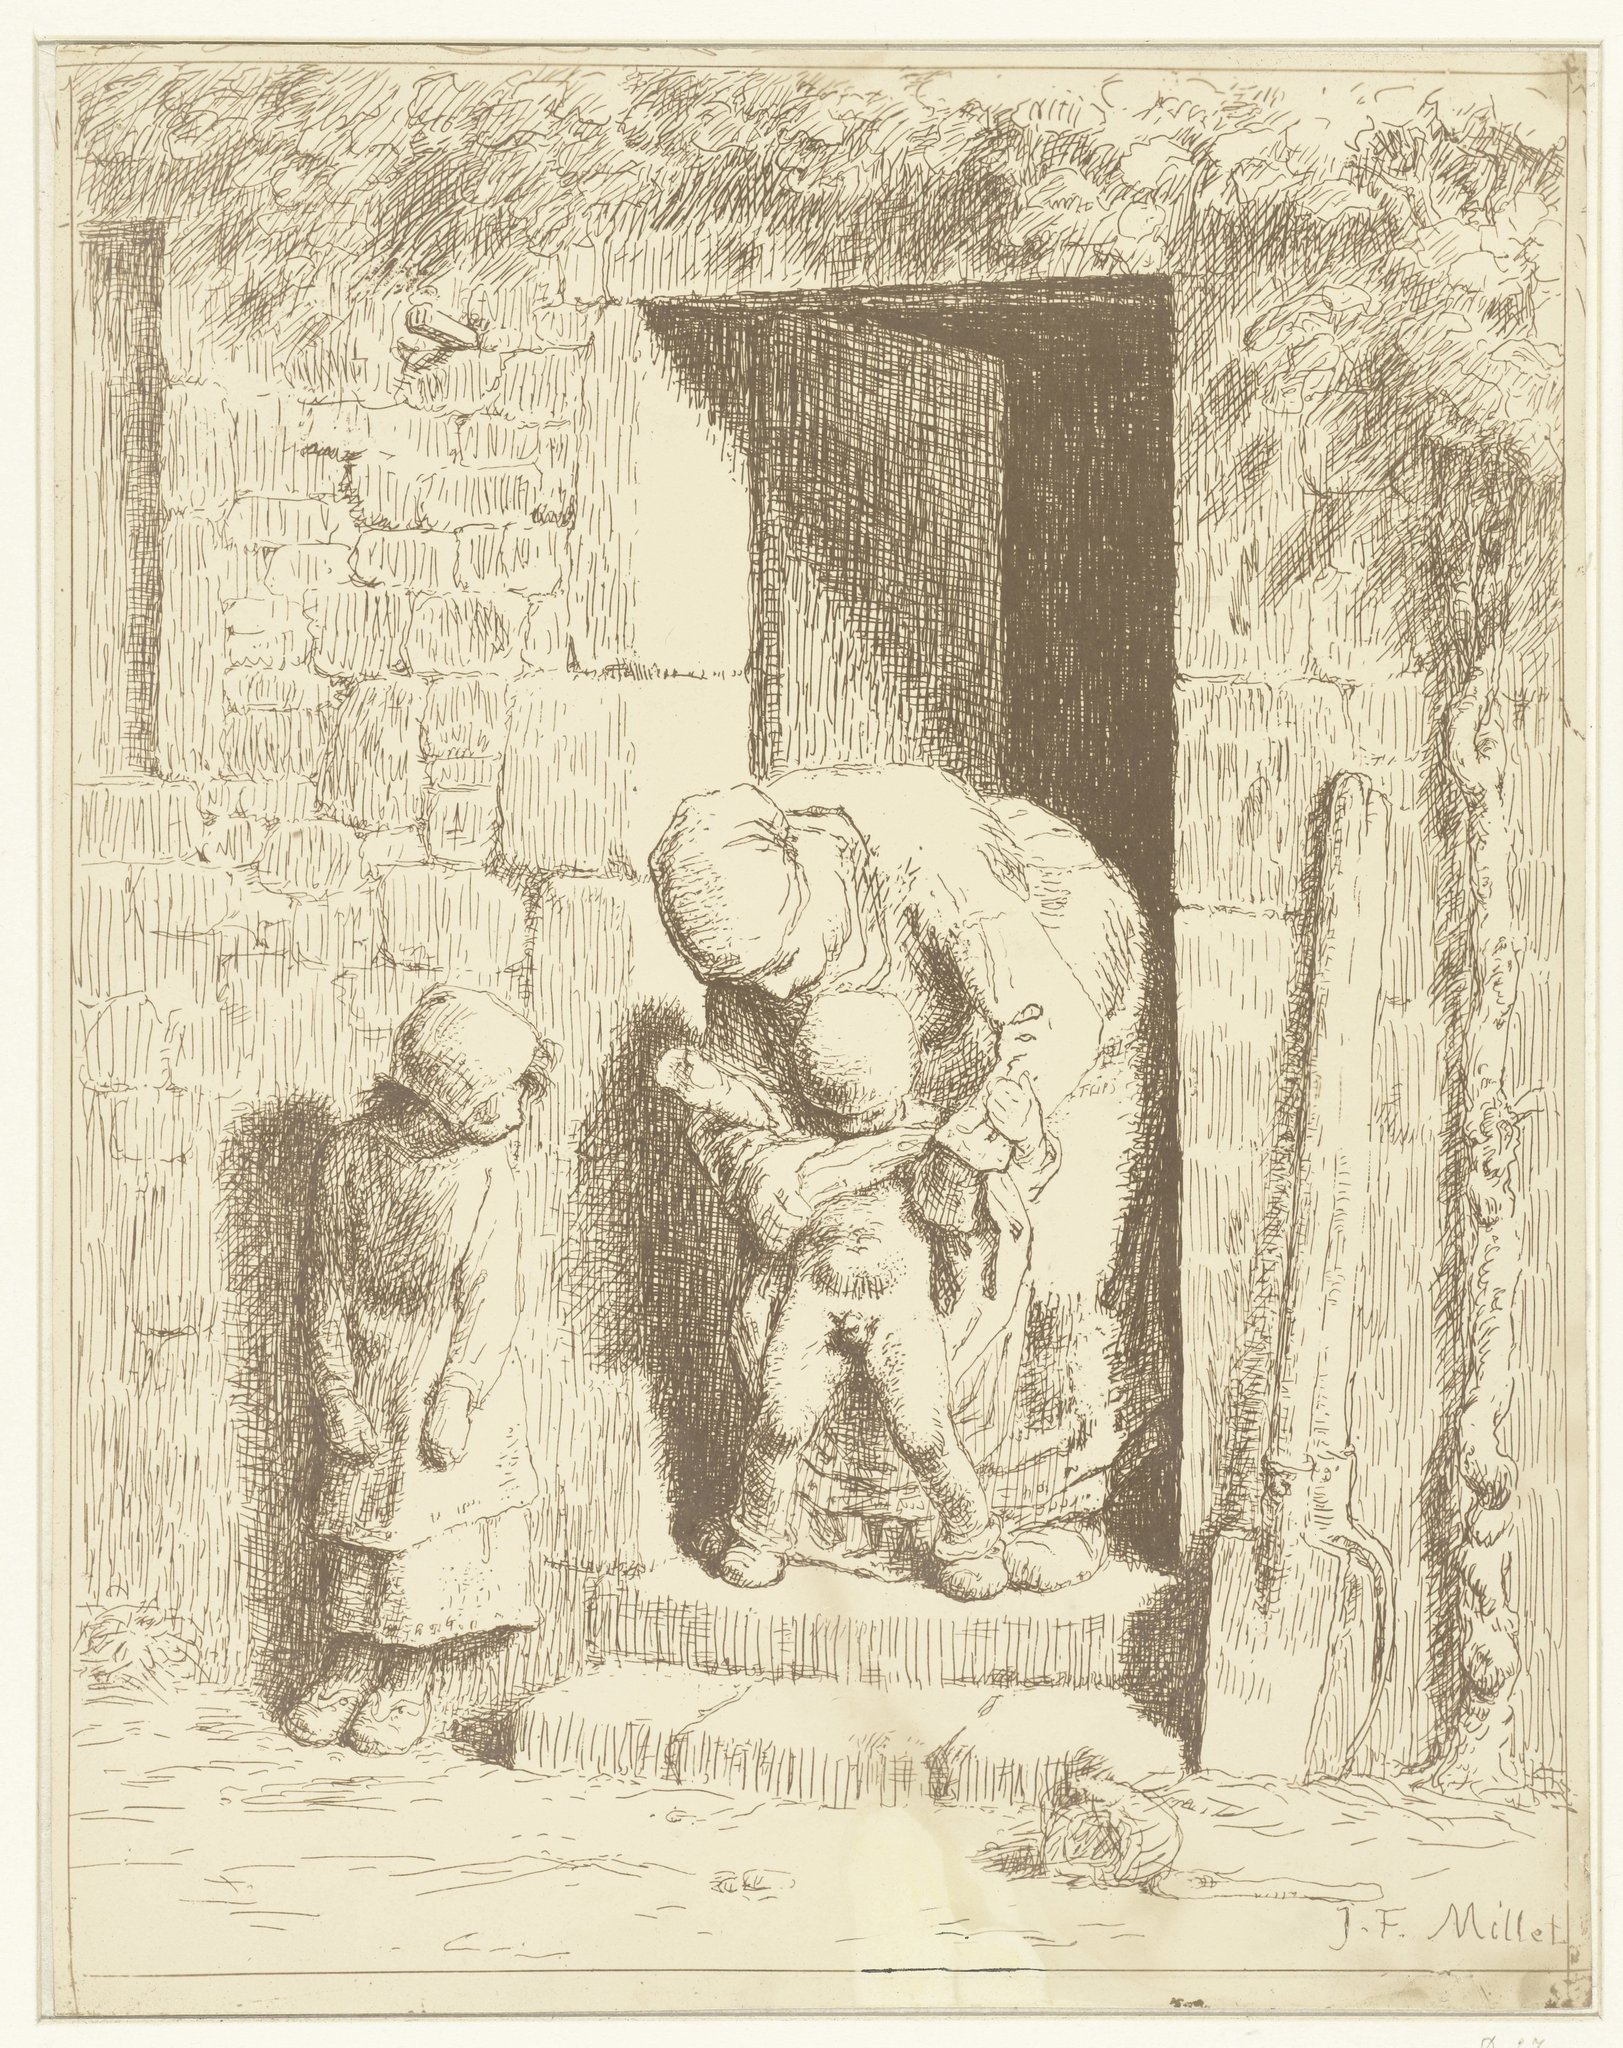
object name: print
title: La Précaution maternelle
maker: jean françois millet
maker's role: draughtsman, painter, print maker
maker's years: 1814-1875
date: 1862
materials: paper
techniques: cliché verre, printing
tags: mother and baby or young child, mother and child(ren), woman and child(ren) (family group)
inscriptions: collector's mark: Lugt 2760, collector's mark: Lugt 2228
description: Moeder staat in de deuropening met een jongetje dat moet plassen, een meisje kijkt toe.